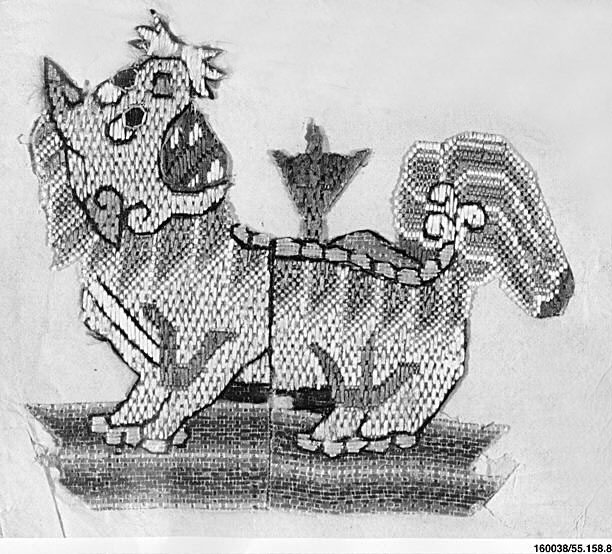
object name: appliqué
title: Applique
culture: chinese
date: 1867-1933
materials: silk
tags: animals